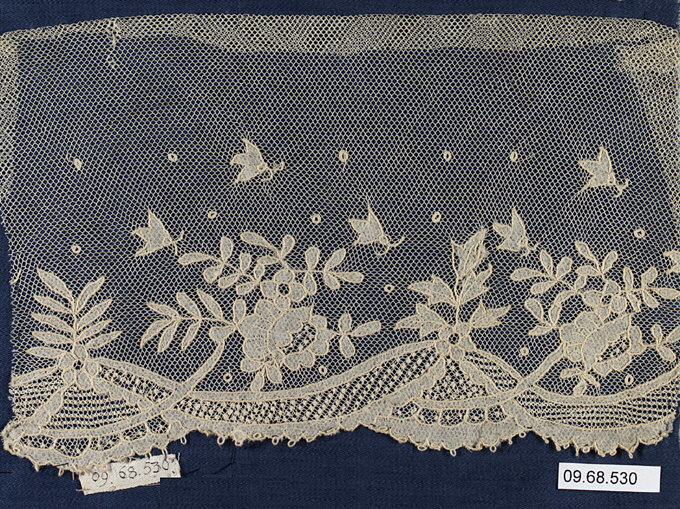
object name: fragment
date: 1890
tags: insects,flowers